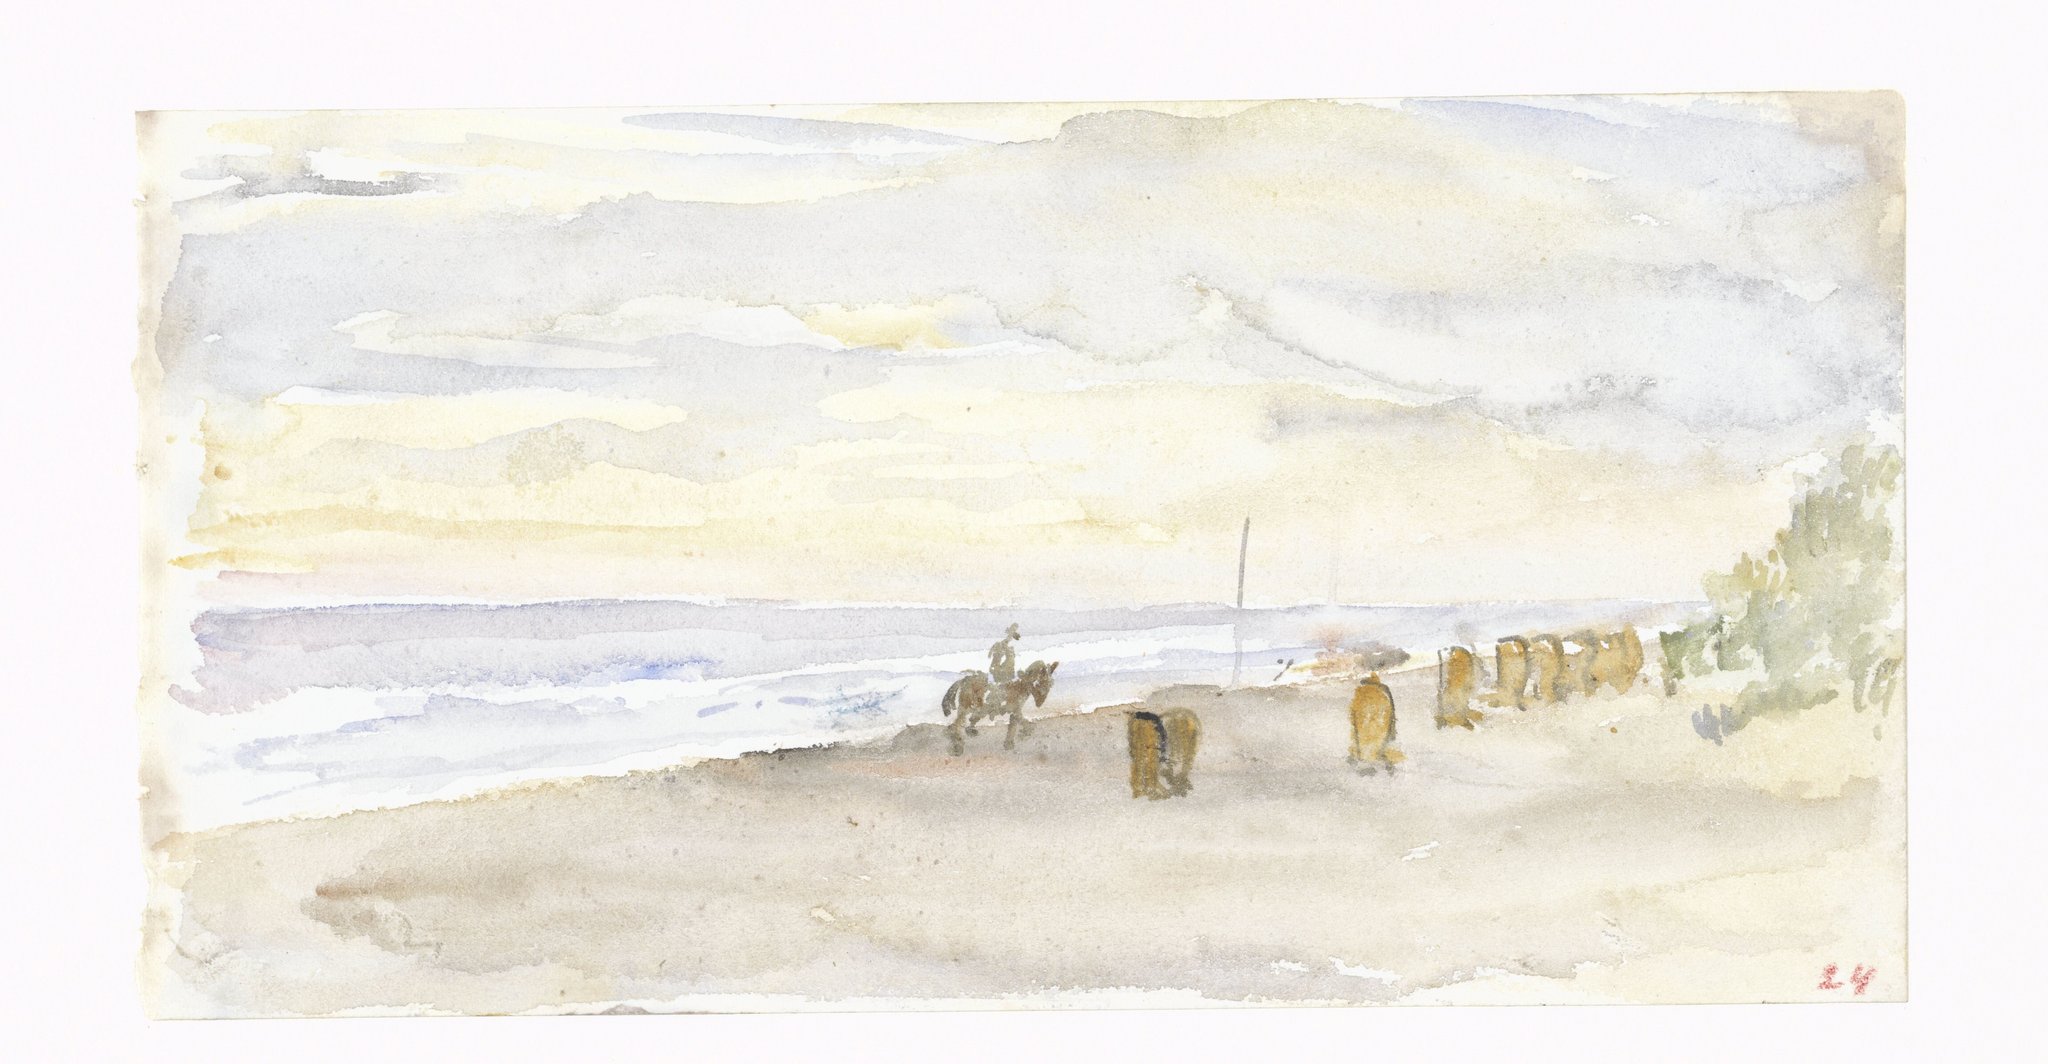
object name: watercolor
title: Strandgezicht met ruiter en badstoelen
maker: jozef israëls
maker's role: draughtsman, painter, print maker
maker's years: 1824-1911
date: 1834-1911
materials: paper, watercolor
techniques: brush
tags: beach